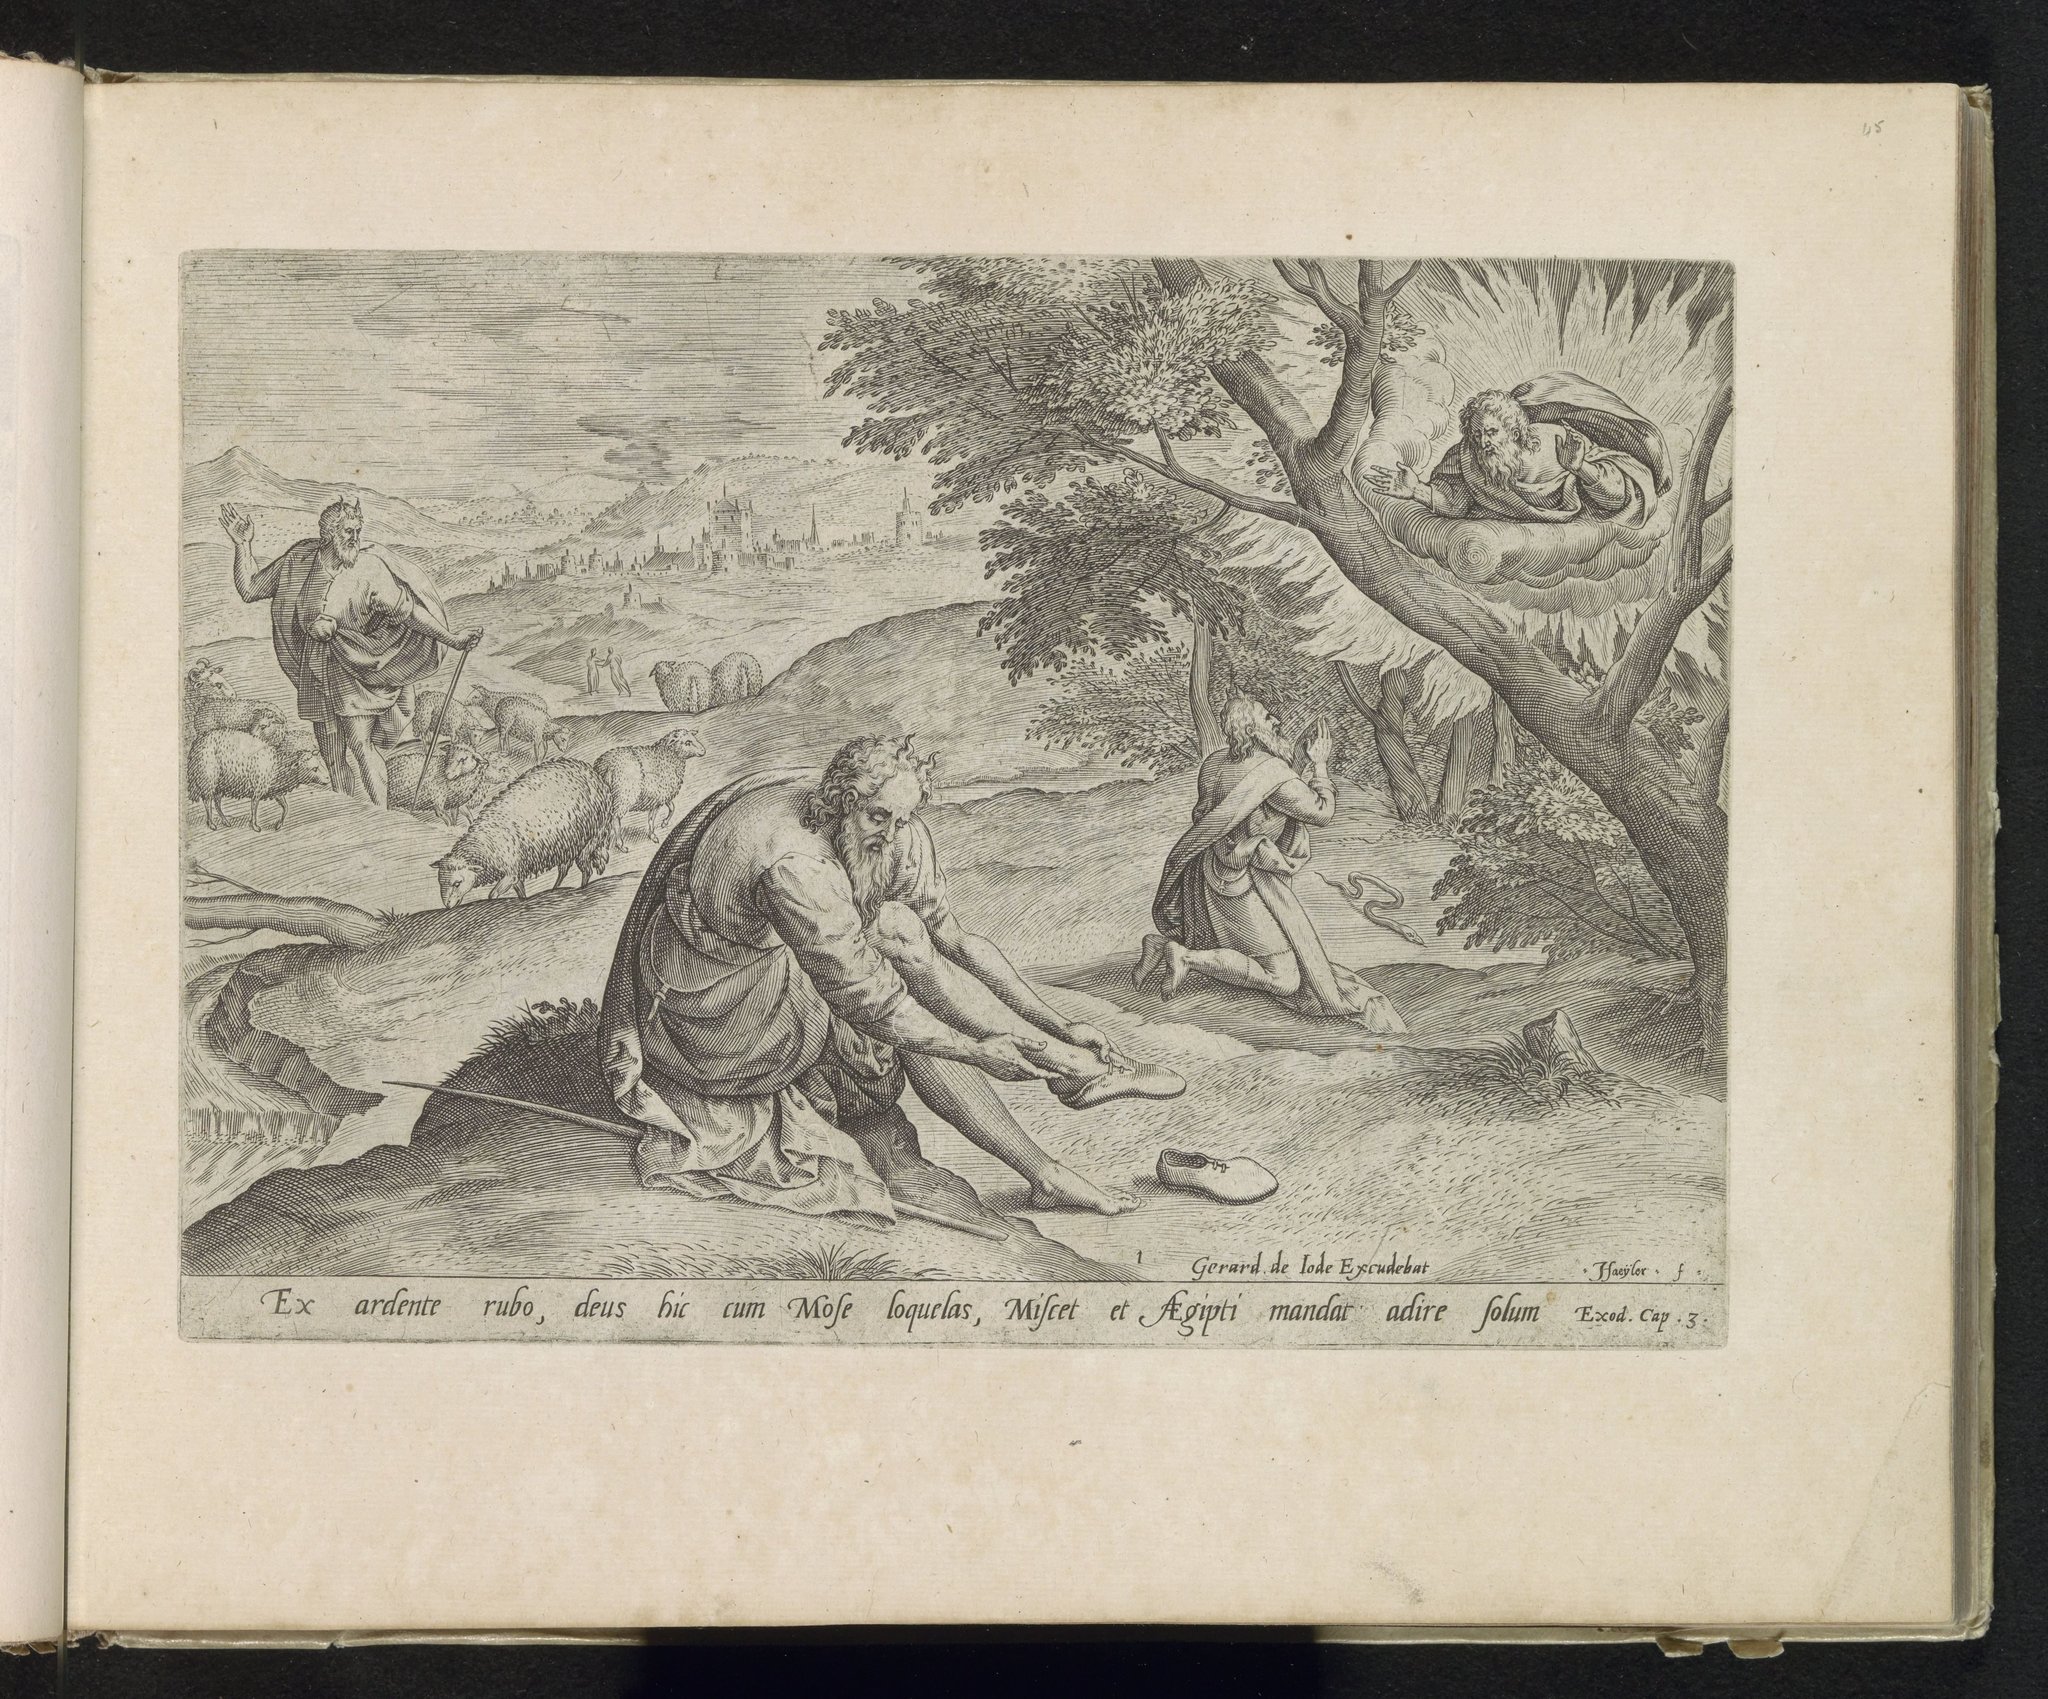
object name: print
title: God verschijnt aan Mozes in het brandende braambos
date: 1585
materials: paper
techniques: engraving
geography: antwerp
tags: while tending jethro's flock moses comes to horeb, moses taking off his sandals, moses, kneeling before the bush and hiding his face, listens to god, a burning bush attracts moses' attention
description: Op de voorgrond trekt Mozes zijn schoenen uit. Op het tweede plan rechts knielt Mozes voor het brandende braambos, waarin God verschijnt. Op de achtergrond links hoedt Mozes de schapen van zijn schoonvader Jetro. Onder de voorstelling een verwijzing in het Latijn naar de Bijbeltekst in Ex. 3. Deze prent maakt deel uit van een album.